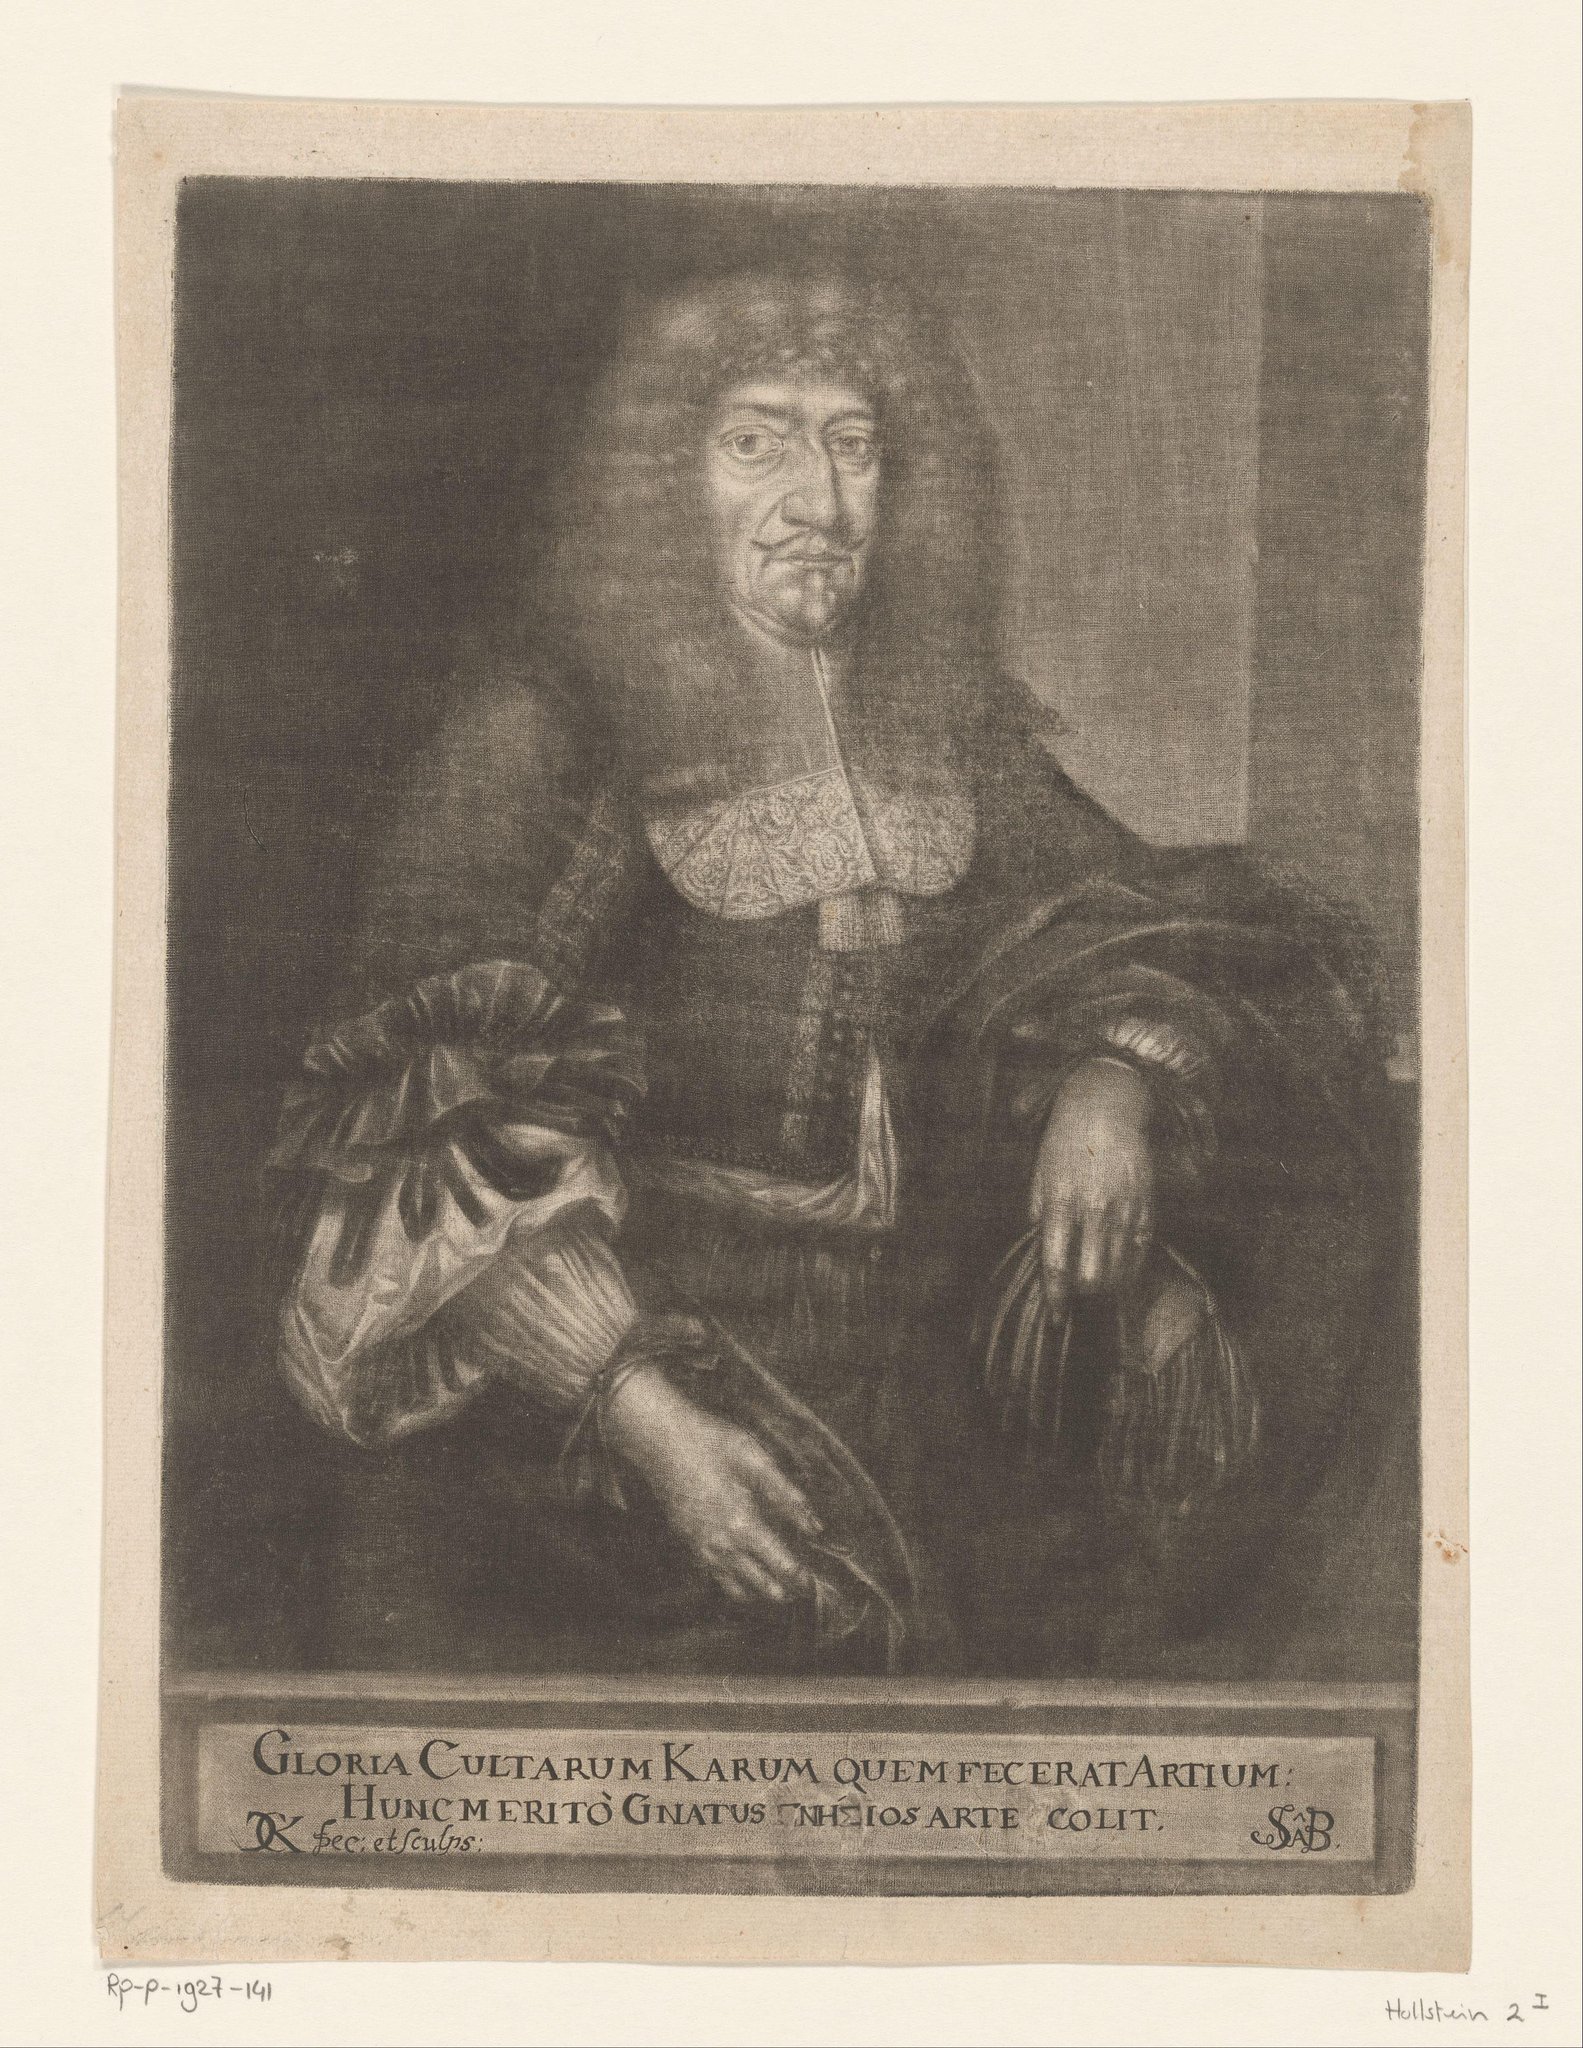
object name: print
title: Portret van Georg Clemens Kretschmann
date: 1690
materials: paper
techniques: mezzotint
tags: gloves, mittens, etc., historical persons